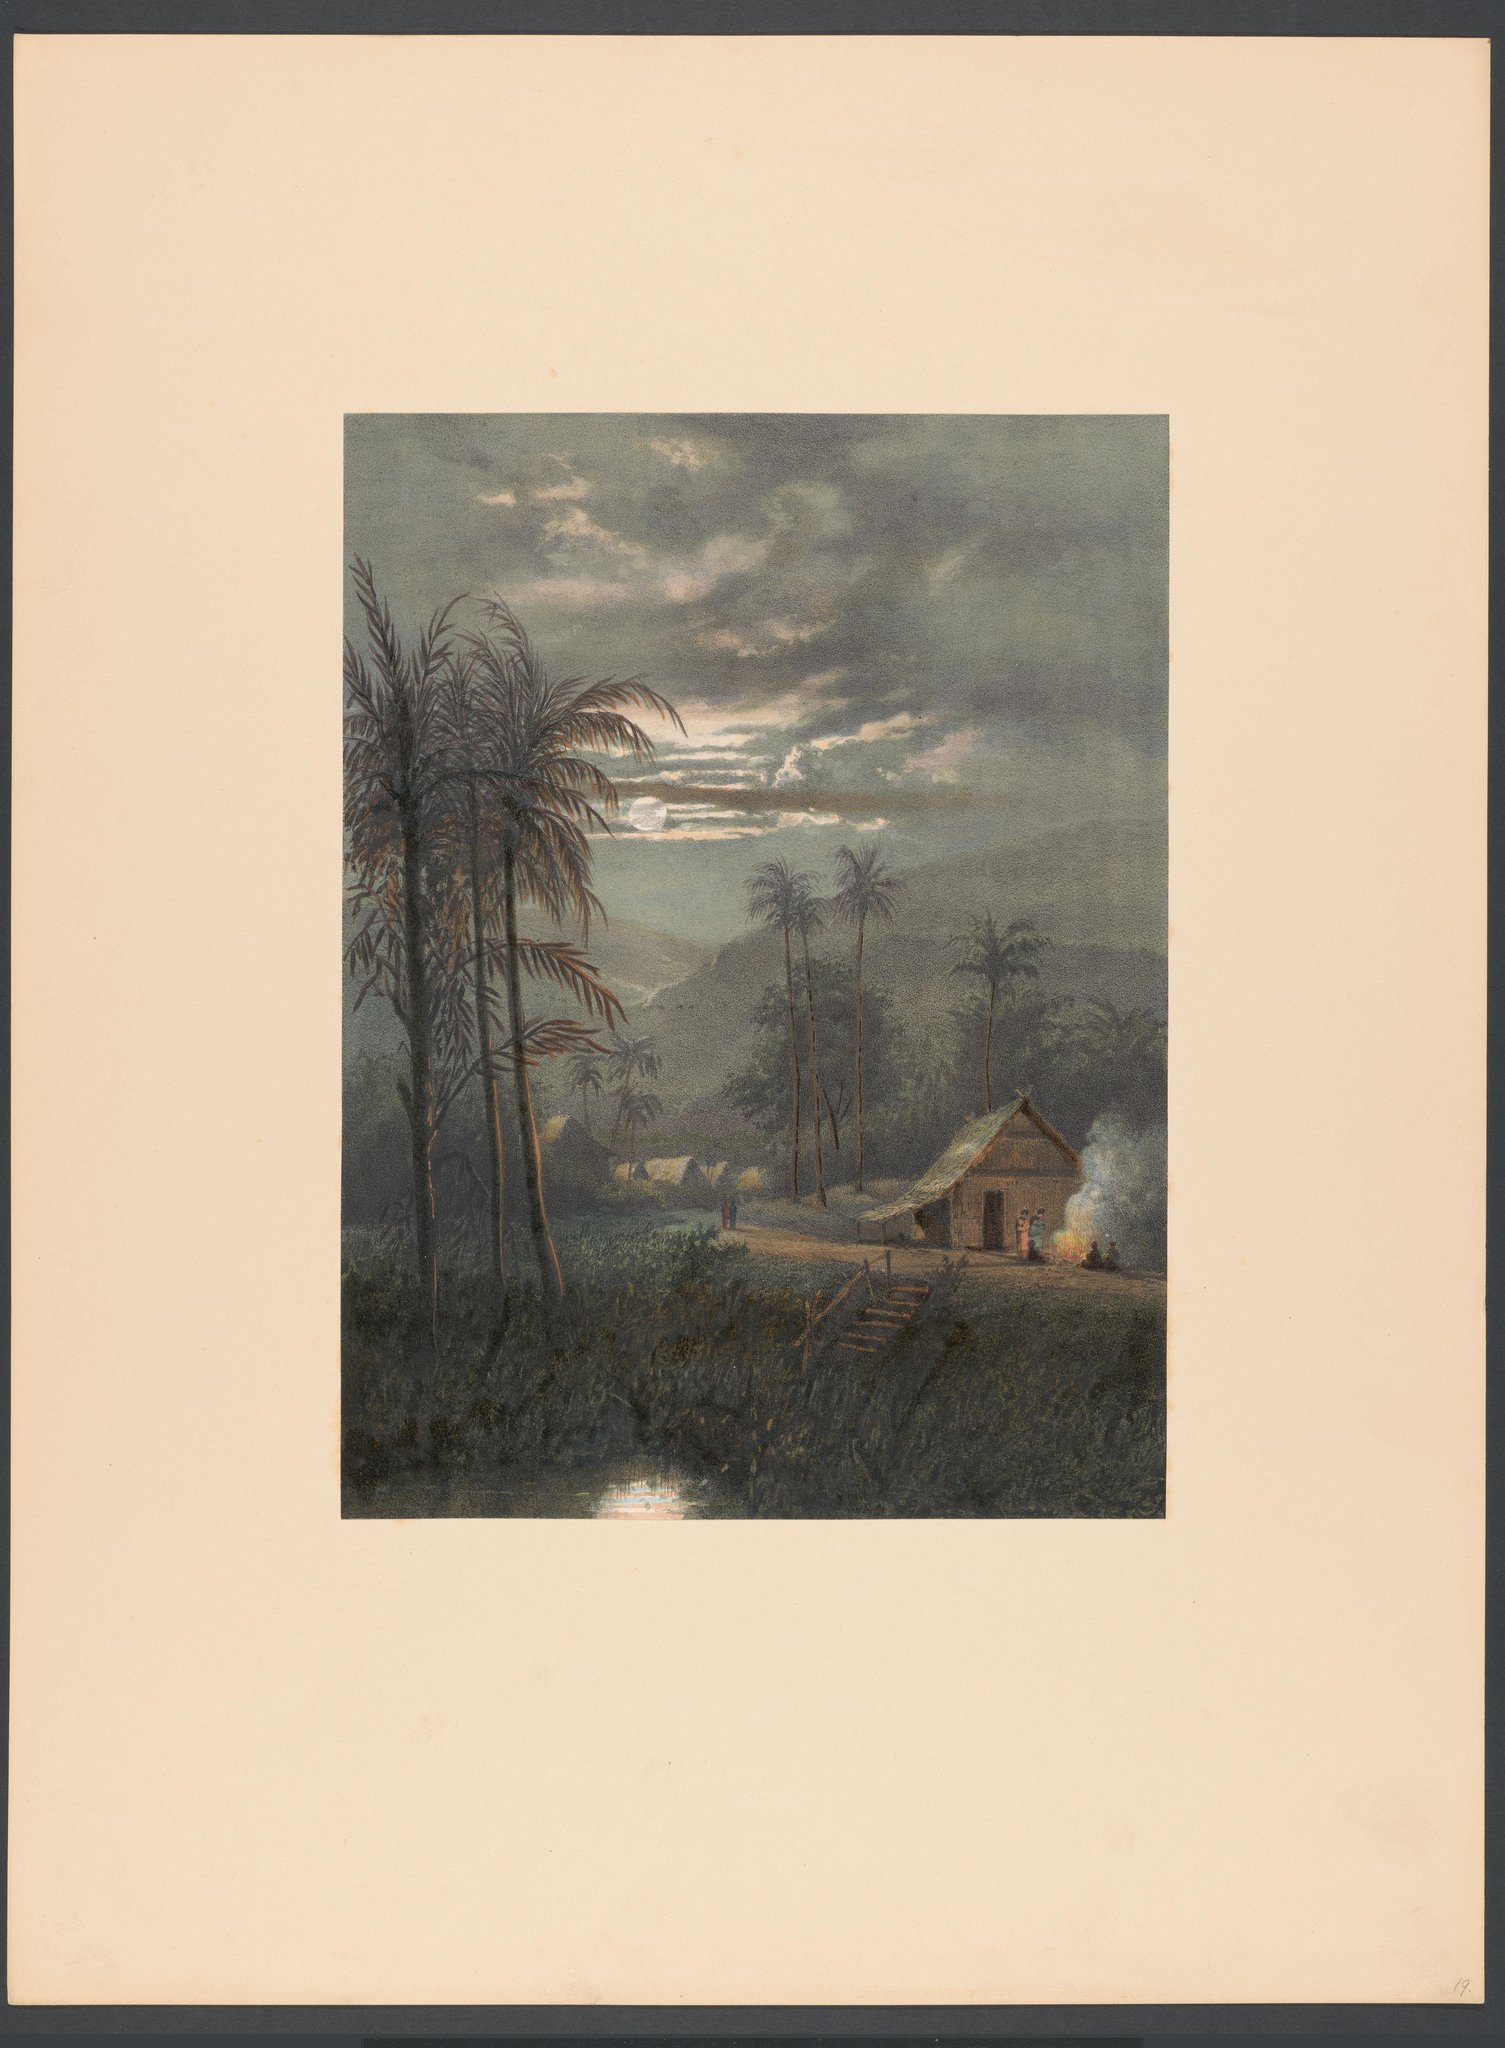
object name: print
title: Java naar schilderijen en teekeningen van A. Salm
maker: johan conrad greive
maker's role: draughtsman, painter, print maker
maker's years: 1837-1891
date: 1865-1872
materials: paper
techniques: lithograph, hand coloring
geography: amsterdam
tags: moonlight, camp-fire; watch-fire, mountains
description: Volgens de bijbehorende inhoudsopgave betreft dit de 19de prent uit de reeks van 24.